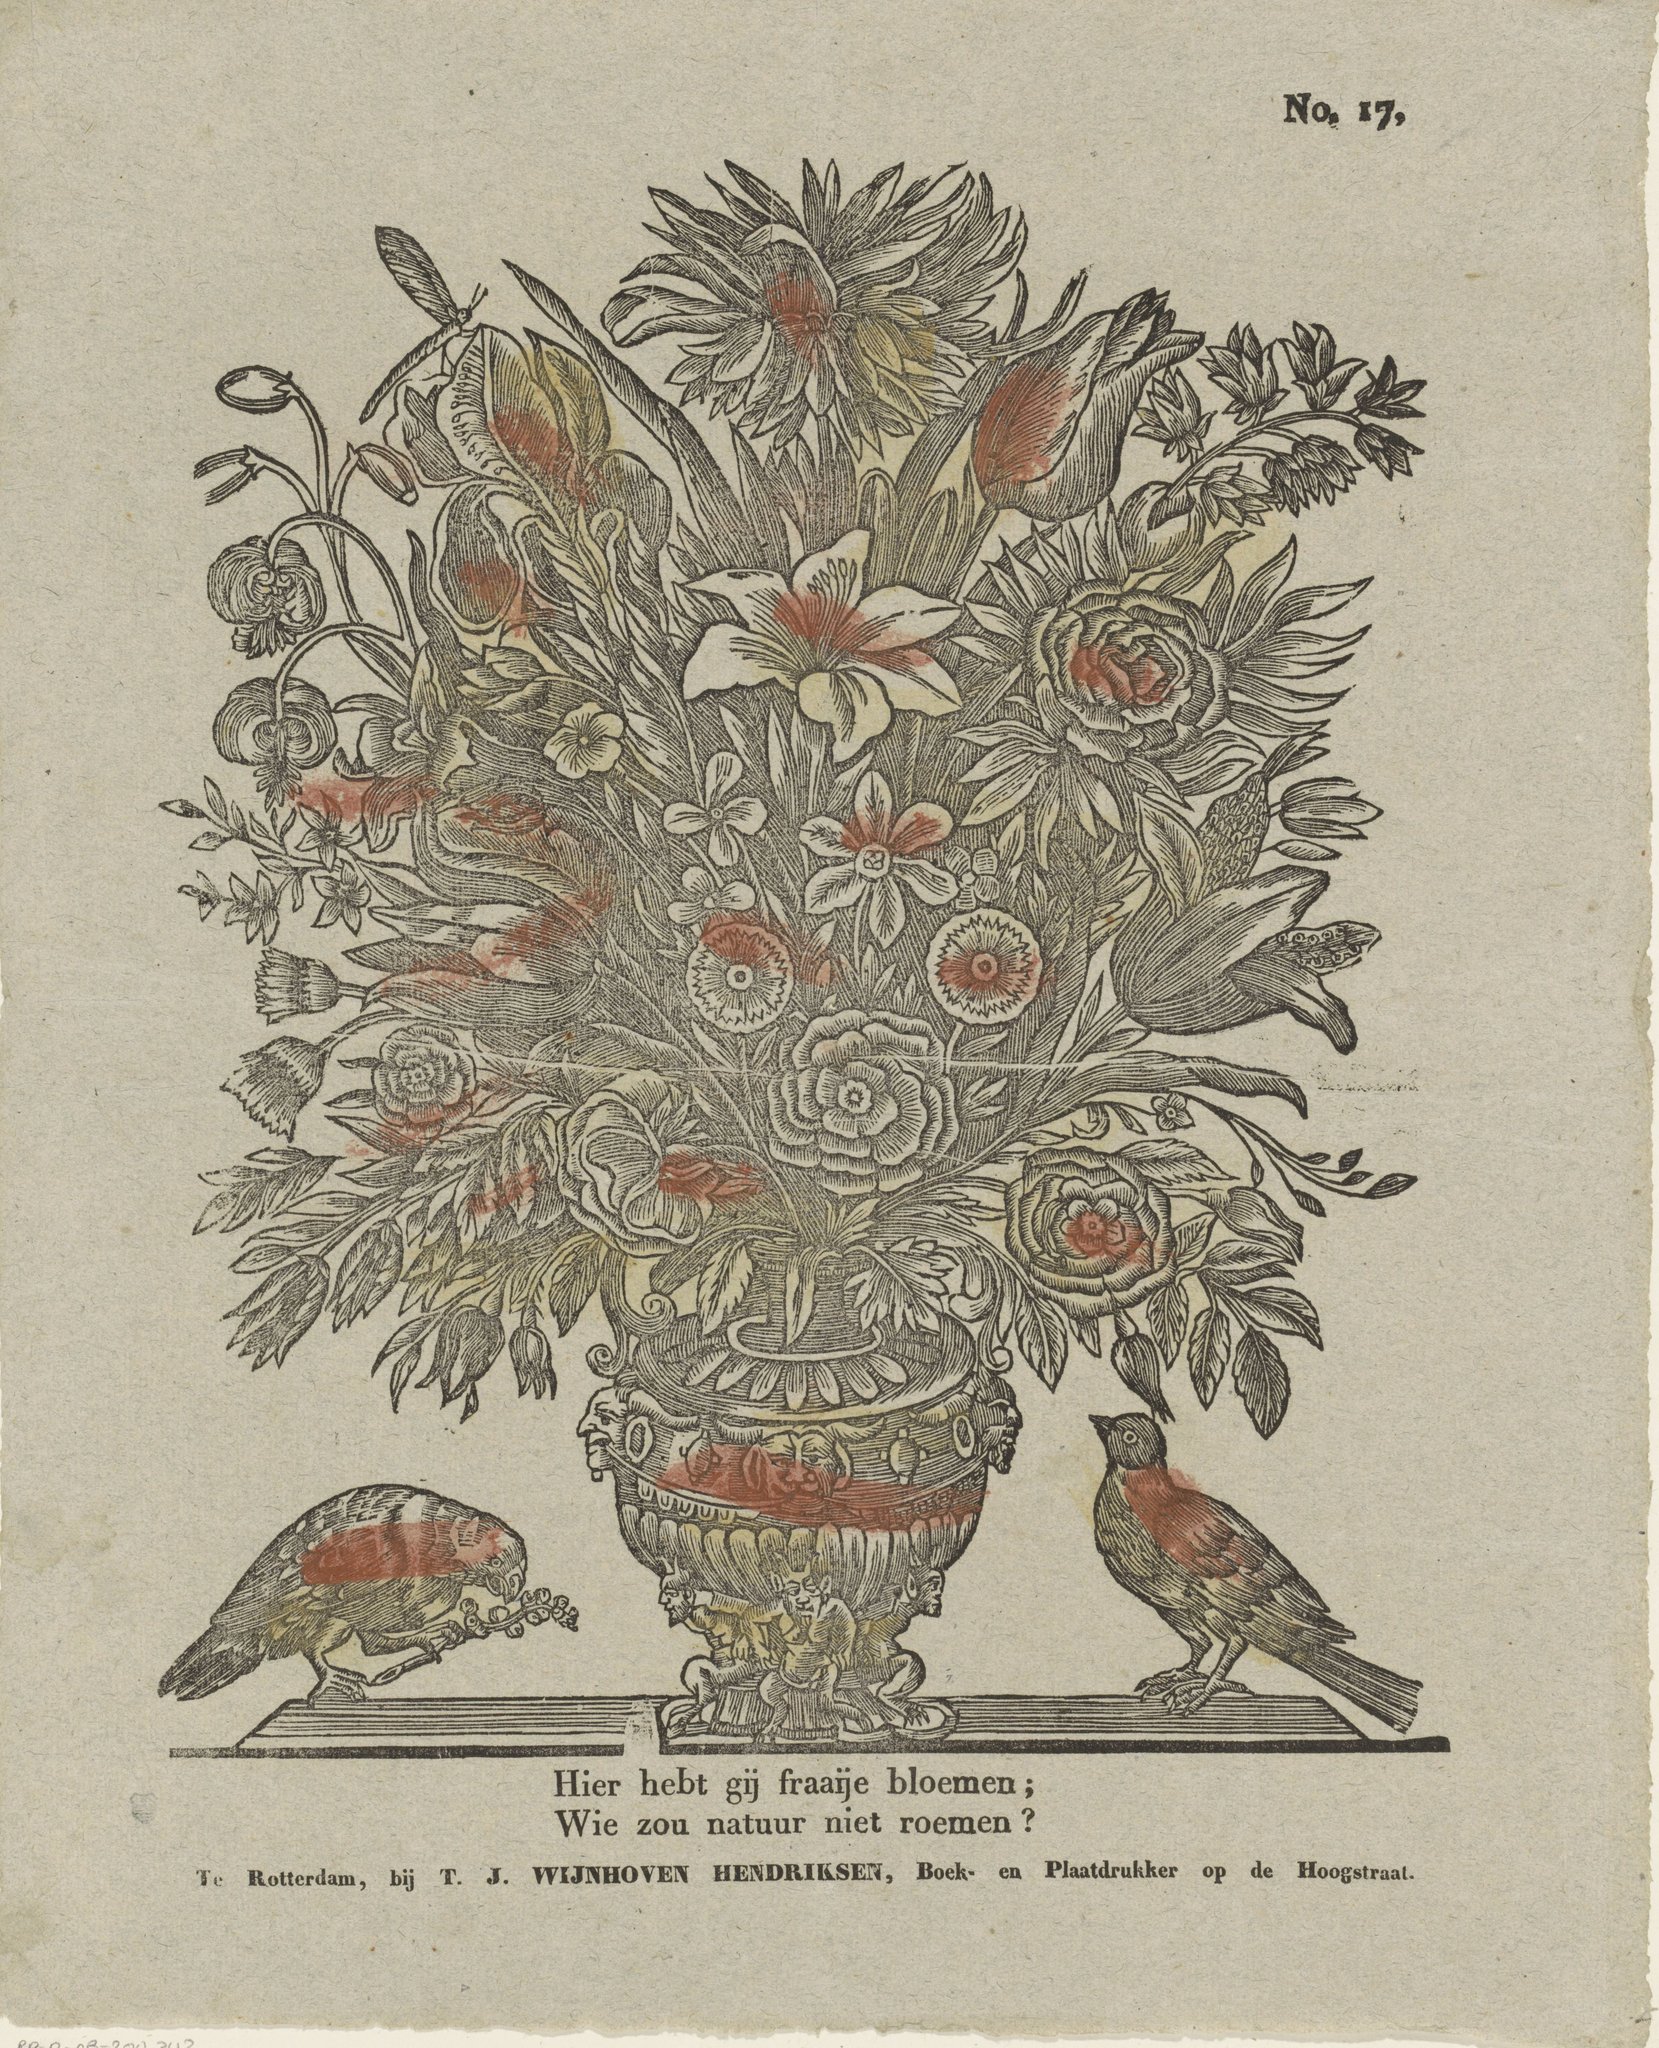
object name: print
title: Hier hebt gij fraaije bloemen; / Wie zou natuur niet roemen?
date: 1832-1850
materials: paper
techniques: colour, letterpress printing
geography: rotterdam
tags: birds, flowers in a vase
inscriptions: collector's mark: Lugt 2760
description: Een vaas met een bos bestaande uit verschillende bloemen, waaronder een roos, een tulp en een viooltje. Aan weerszijden van de vaas een vogel. Genummerd rechtsboven: No. 17.